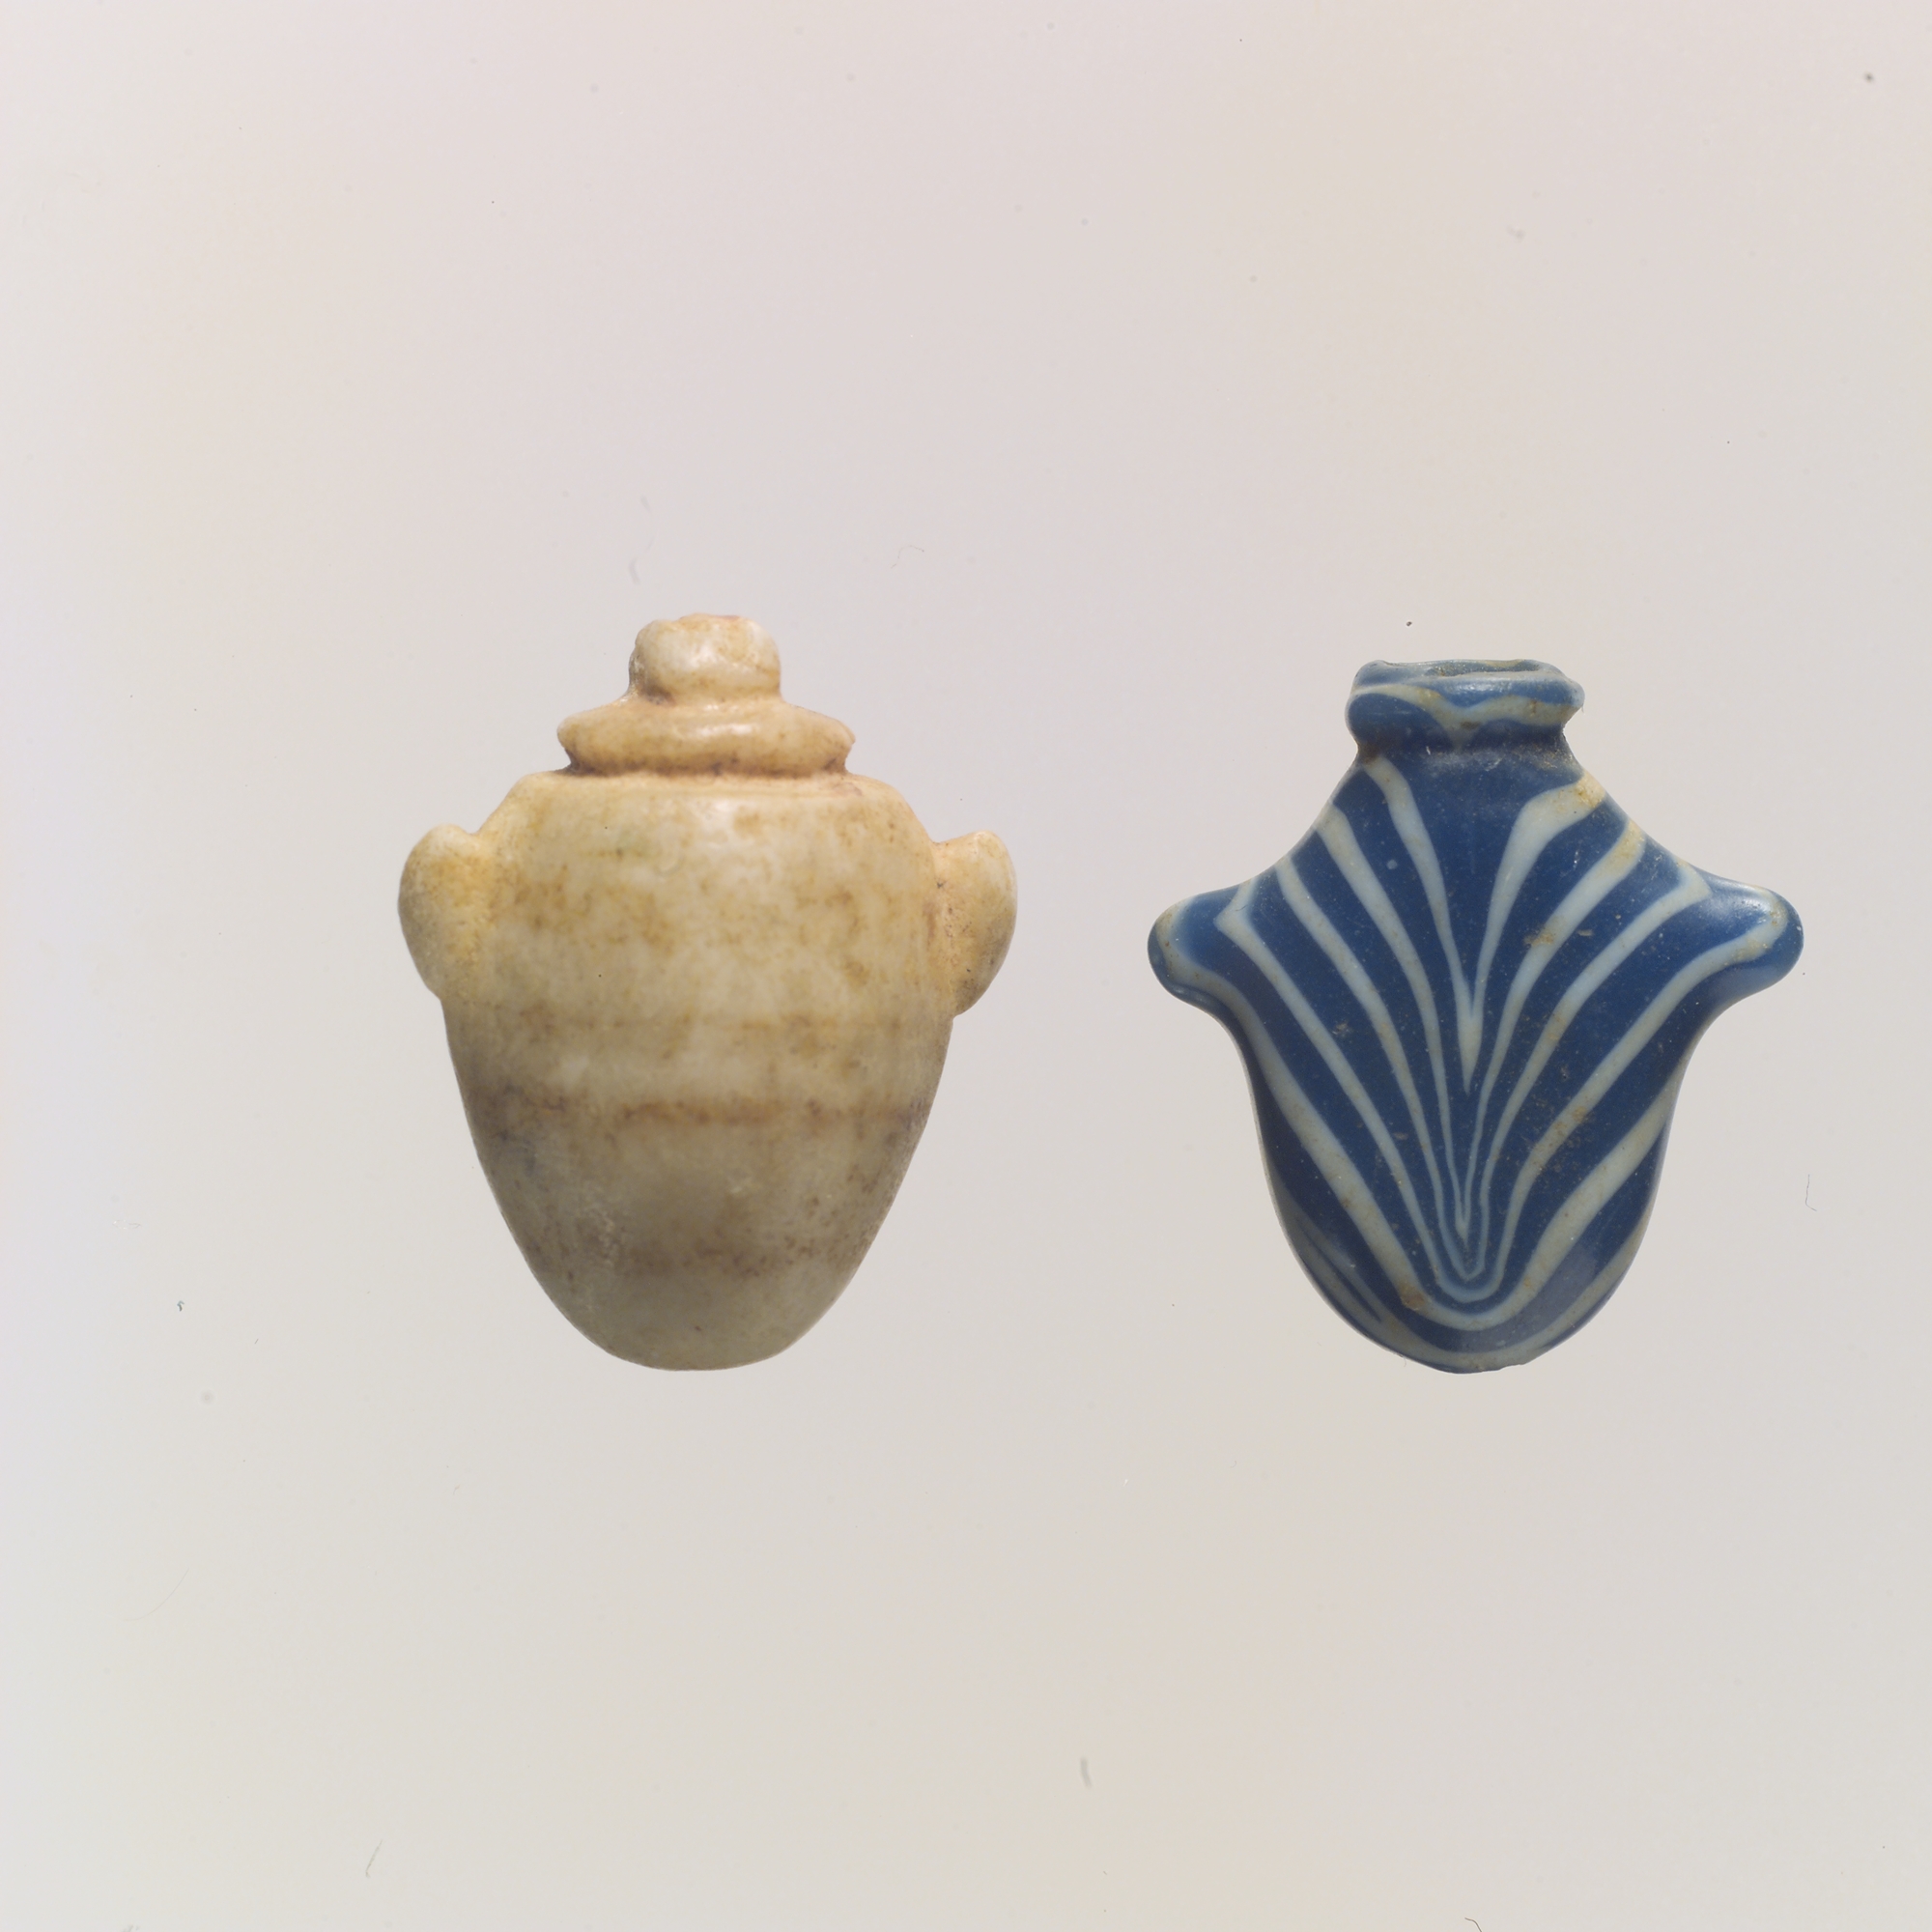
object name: amulet, heart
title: Heart amulet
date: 1550-1186 BCE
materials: stone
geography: egypt